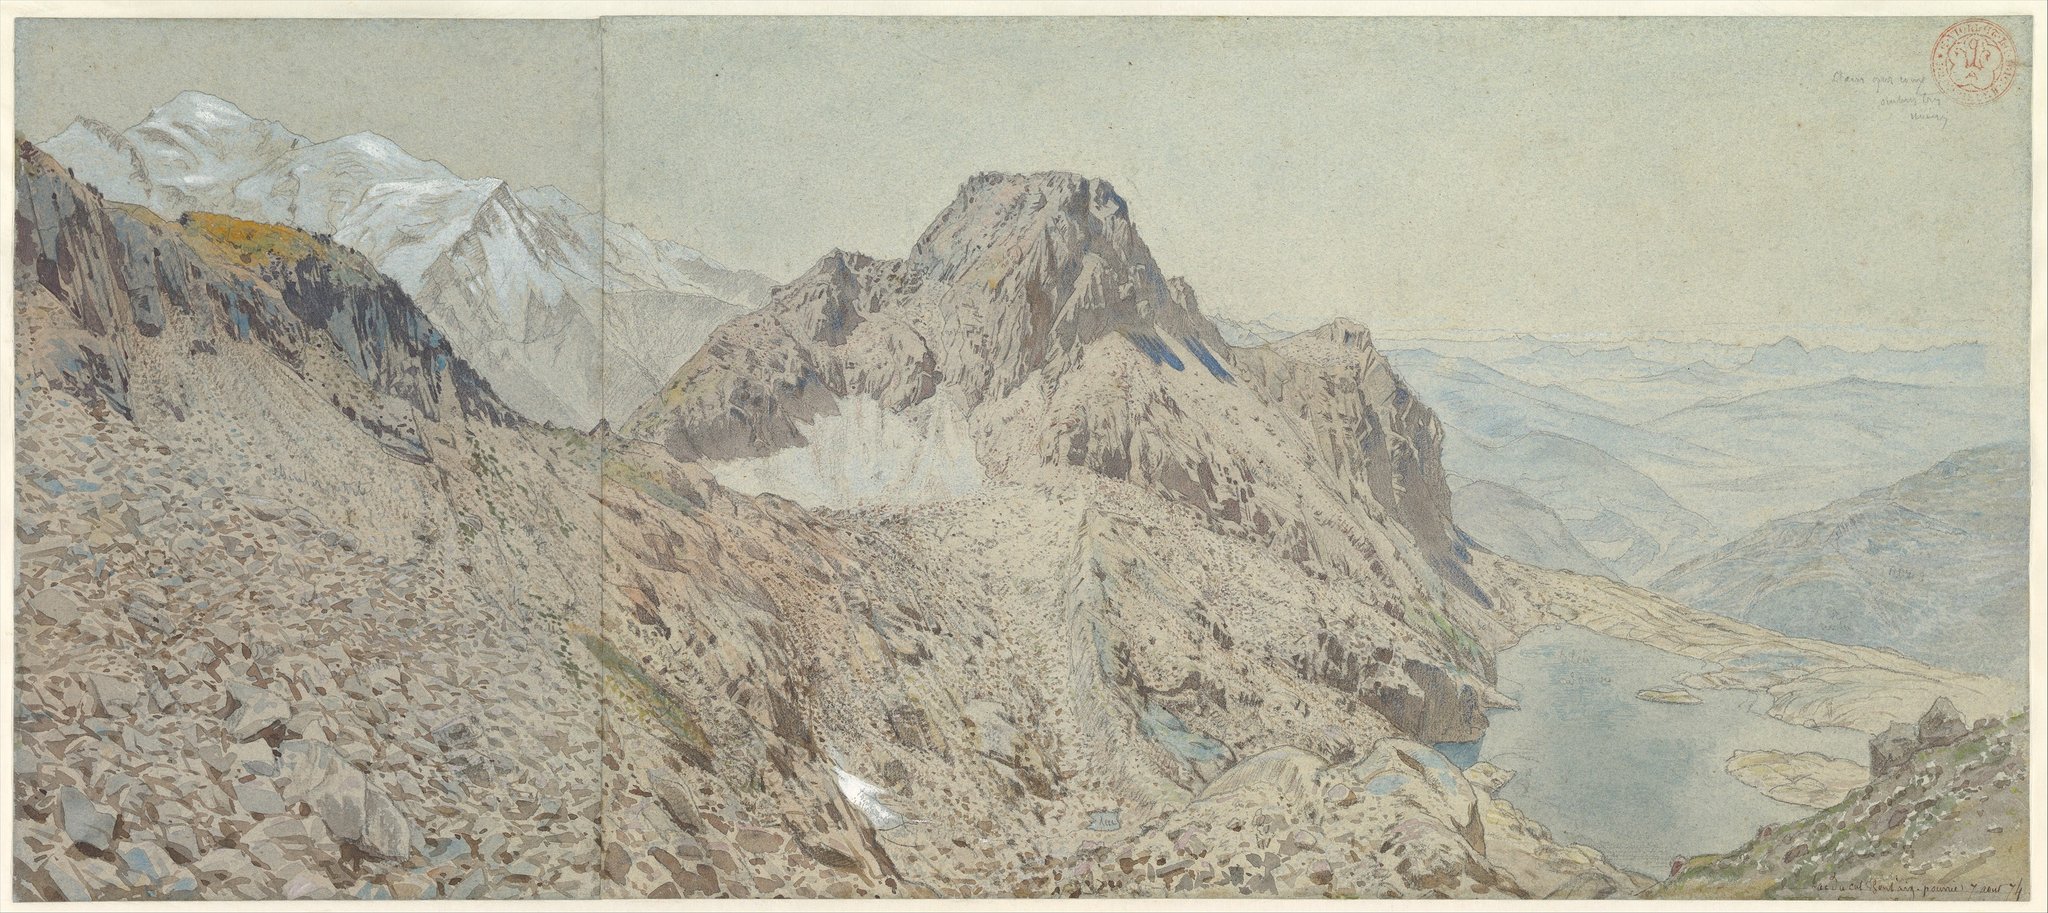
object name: drawing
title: Mont Blanc Seen from the Massif, Les Aiguilles Rouges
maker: eugène-emmanuel viollet-le-duc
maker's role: artist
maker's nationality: french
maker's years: 1814-1879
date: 1874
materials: gouache, graphite, watercolor, paper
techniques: heightening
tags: mountains